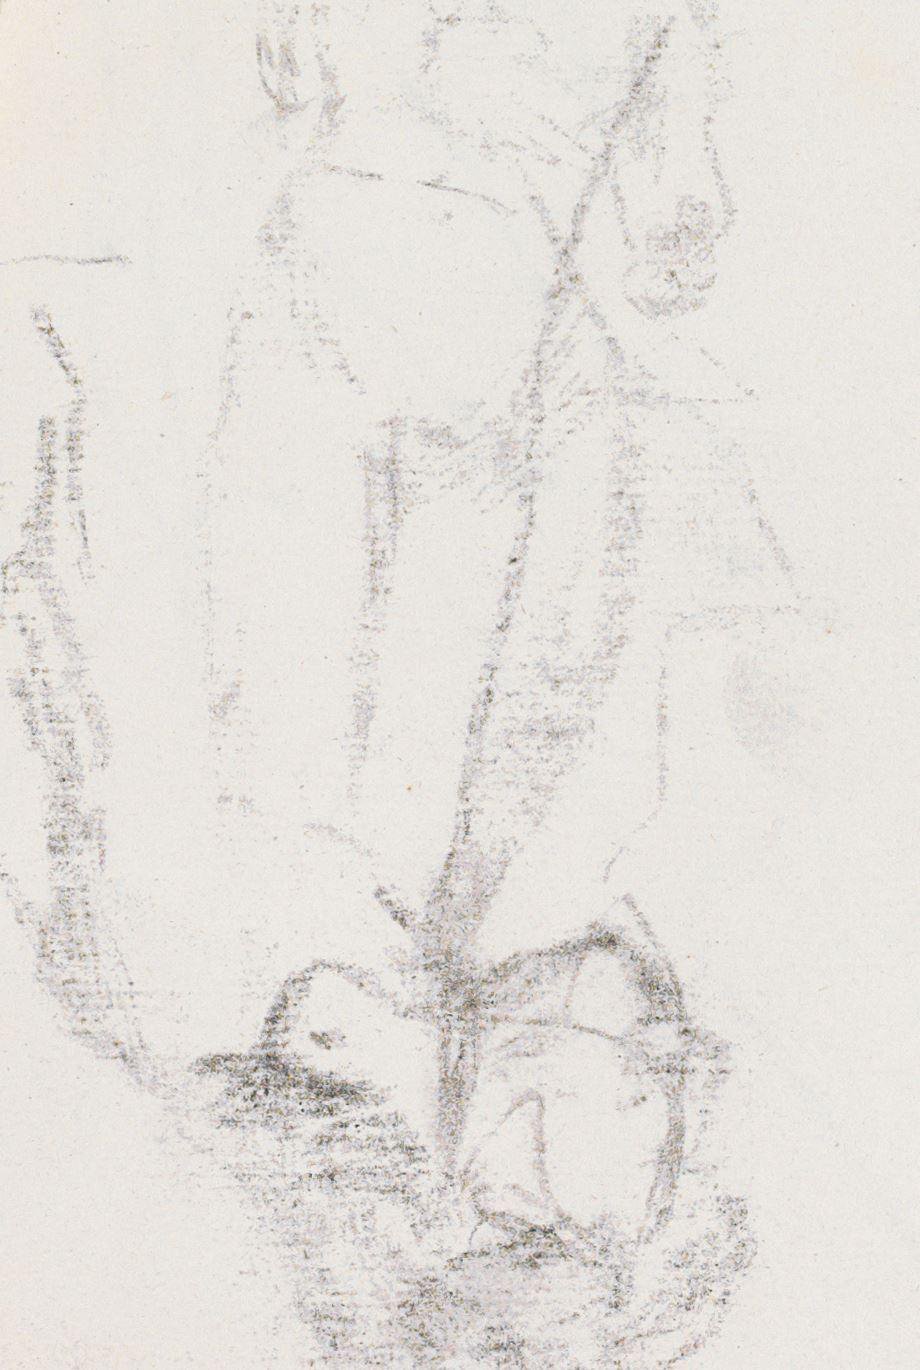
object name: sketchbook leaf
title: Abklatsch van de krijttekening op pagina 21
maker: isaac israels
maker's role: draughtsman, painter, print maker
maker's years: 1865-1934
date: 1875-1934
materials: paper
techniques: printmaking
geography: the hague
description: Pagina 22 uit schetsboek XLIV met 43 pagina's.